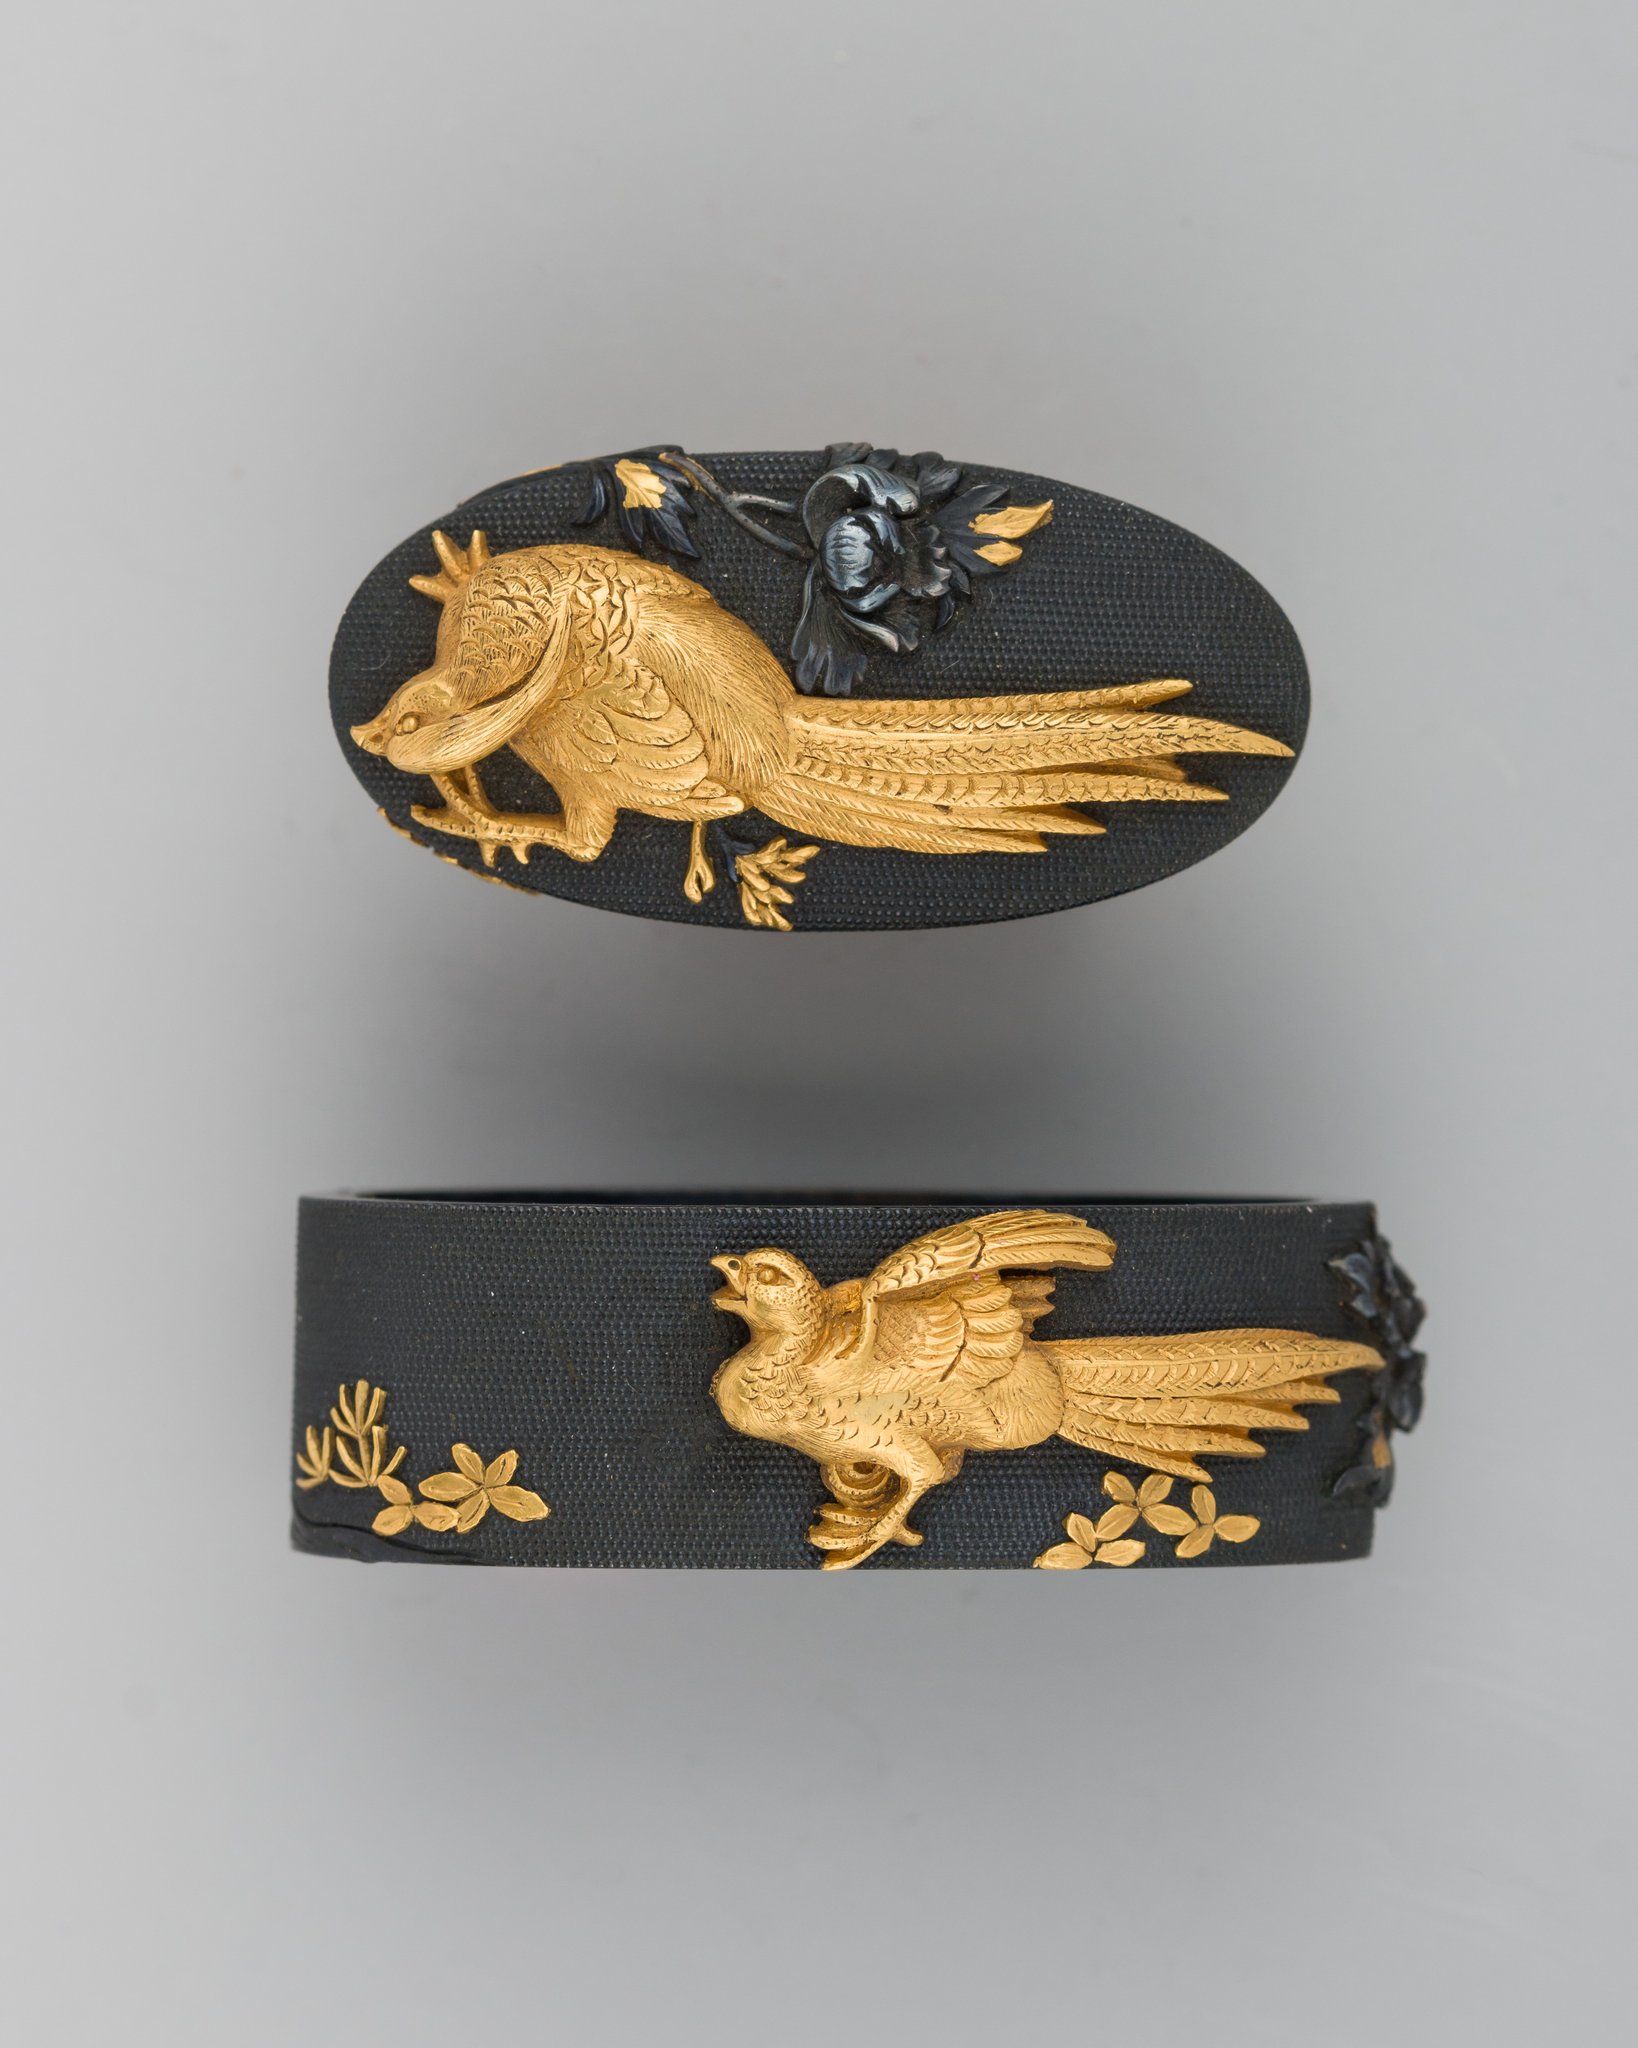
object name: sword hilt collar fuchi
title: Sword-Hilt Collar (Fuchi)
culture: japanese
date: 1801-1900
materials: gold alloy, gold, silver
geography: japan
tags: birds